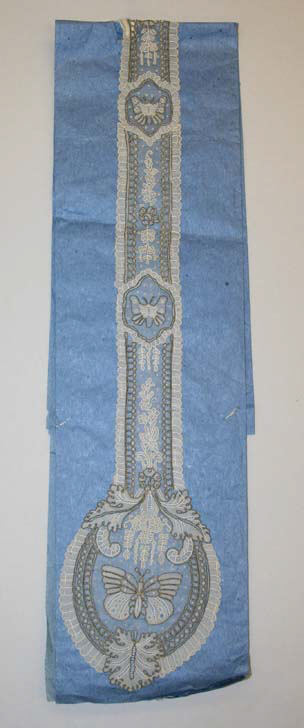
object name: barbe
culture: belgian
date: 1860-1869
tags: butterflies